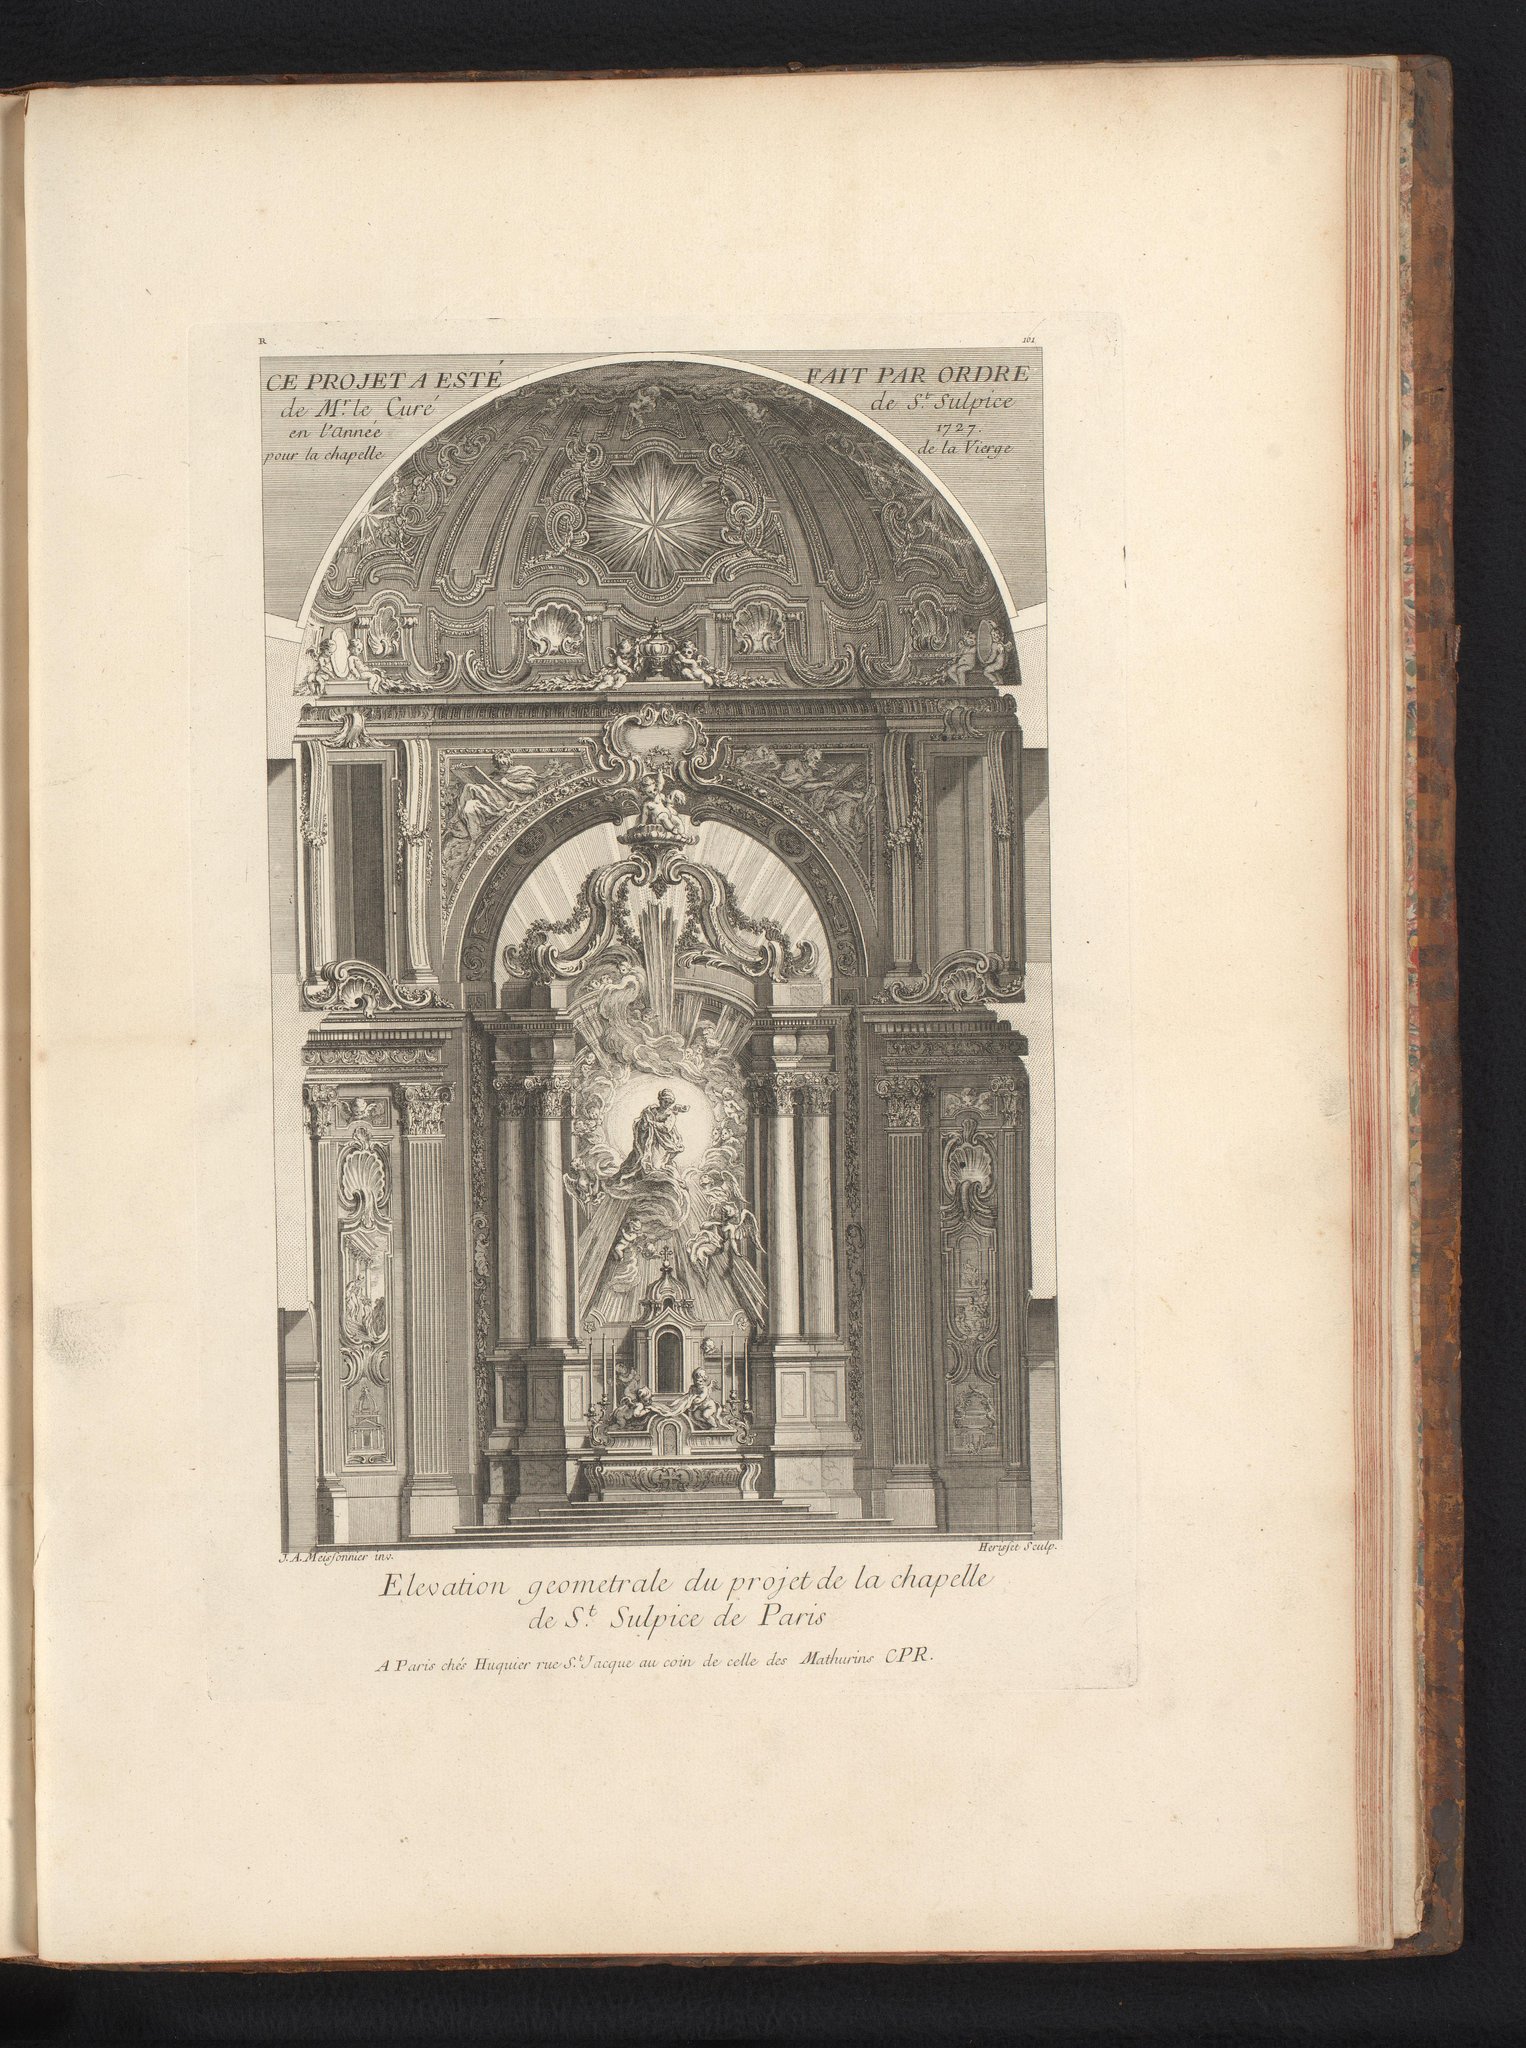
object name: ornament print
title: Ontwerp voor de Mariakapel in de Saint-Sulpice in Parijs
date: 1738-1749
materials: paper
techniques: etching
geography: paris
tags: parts of church interior: chapel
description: Deze prent maakt deel uit van een album.